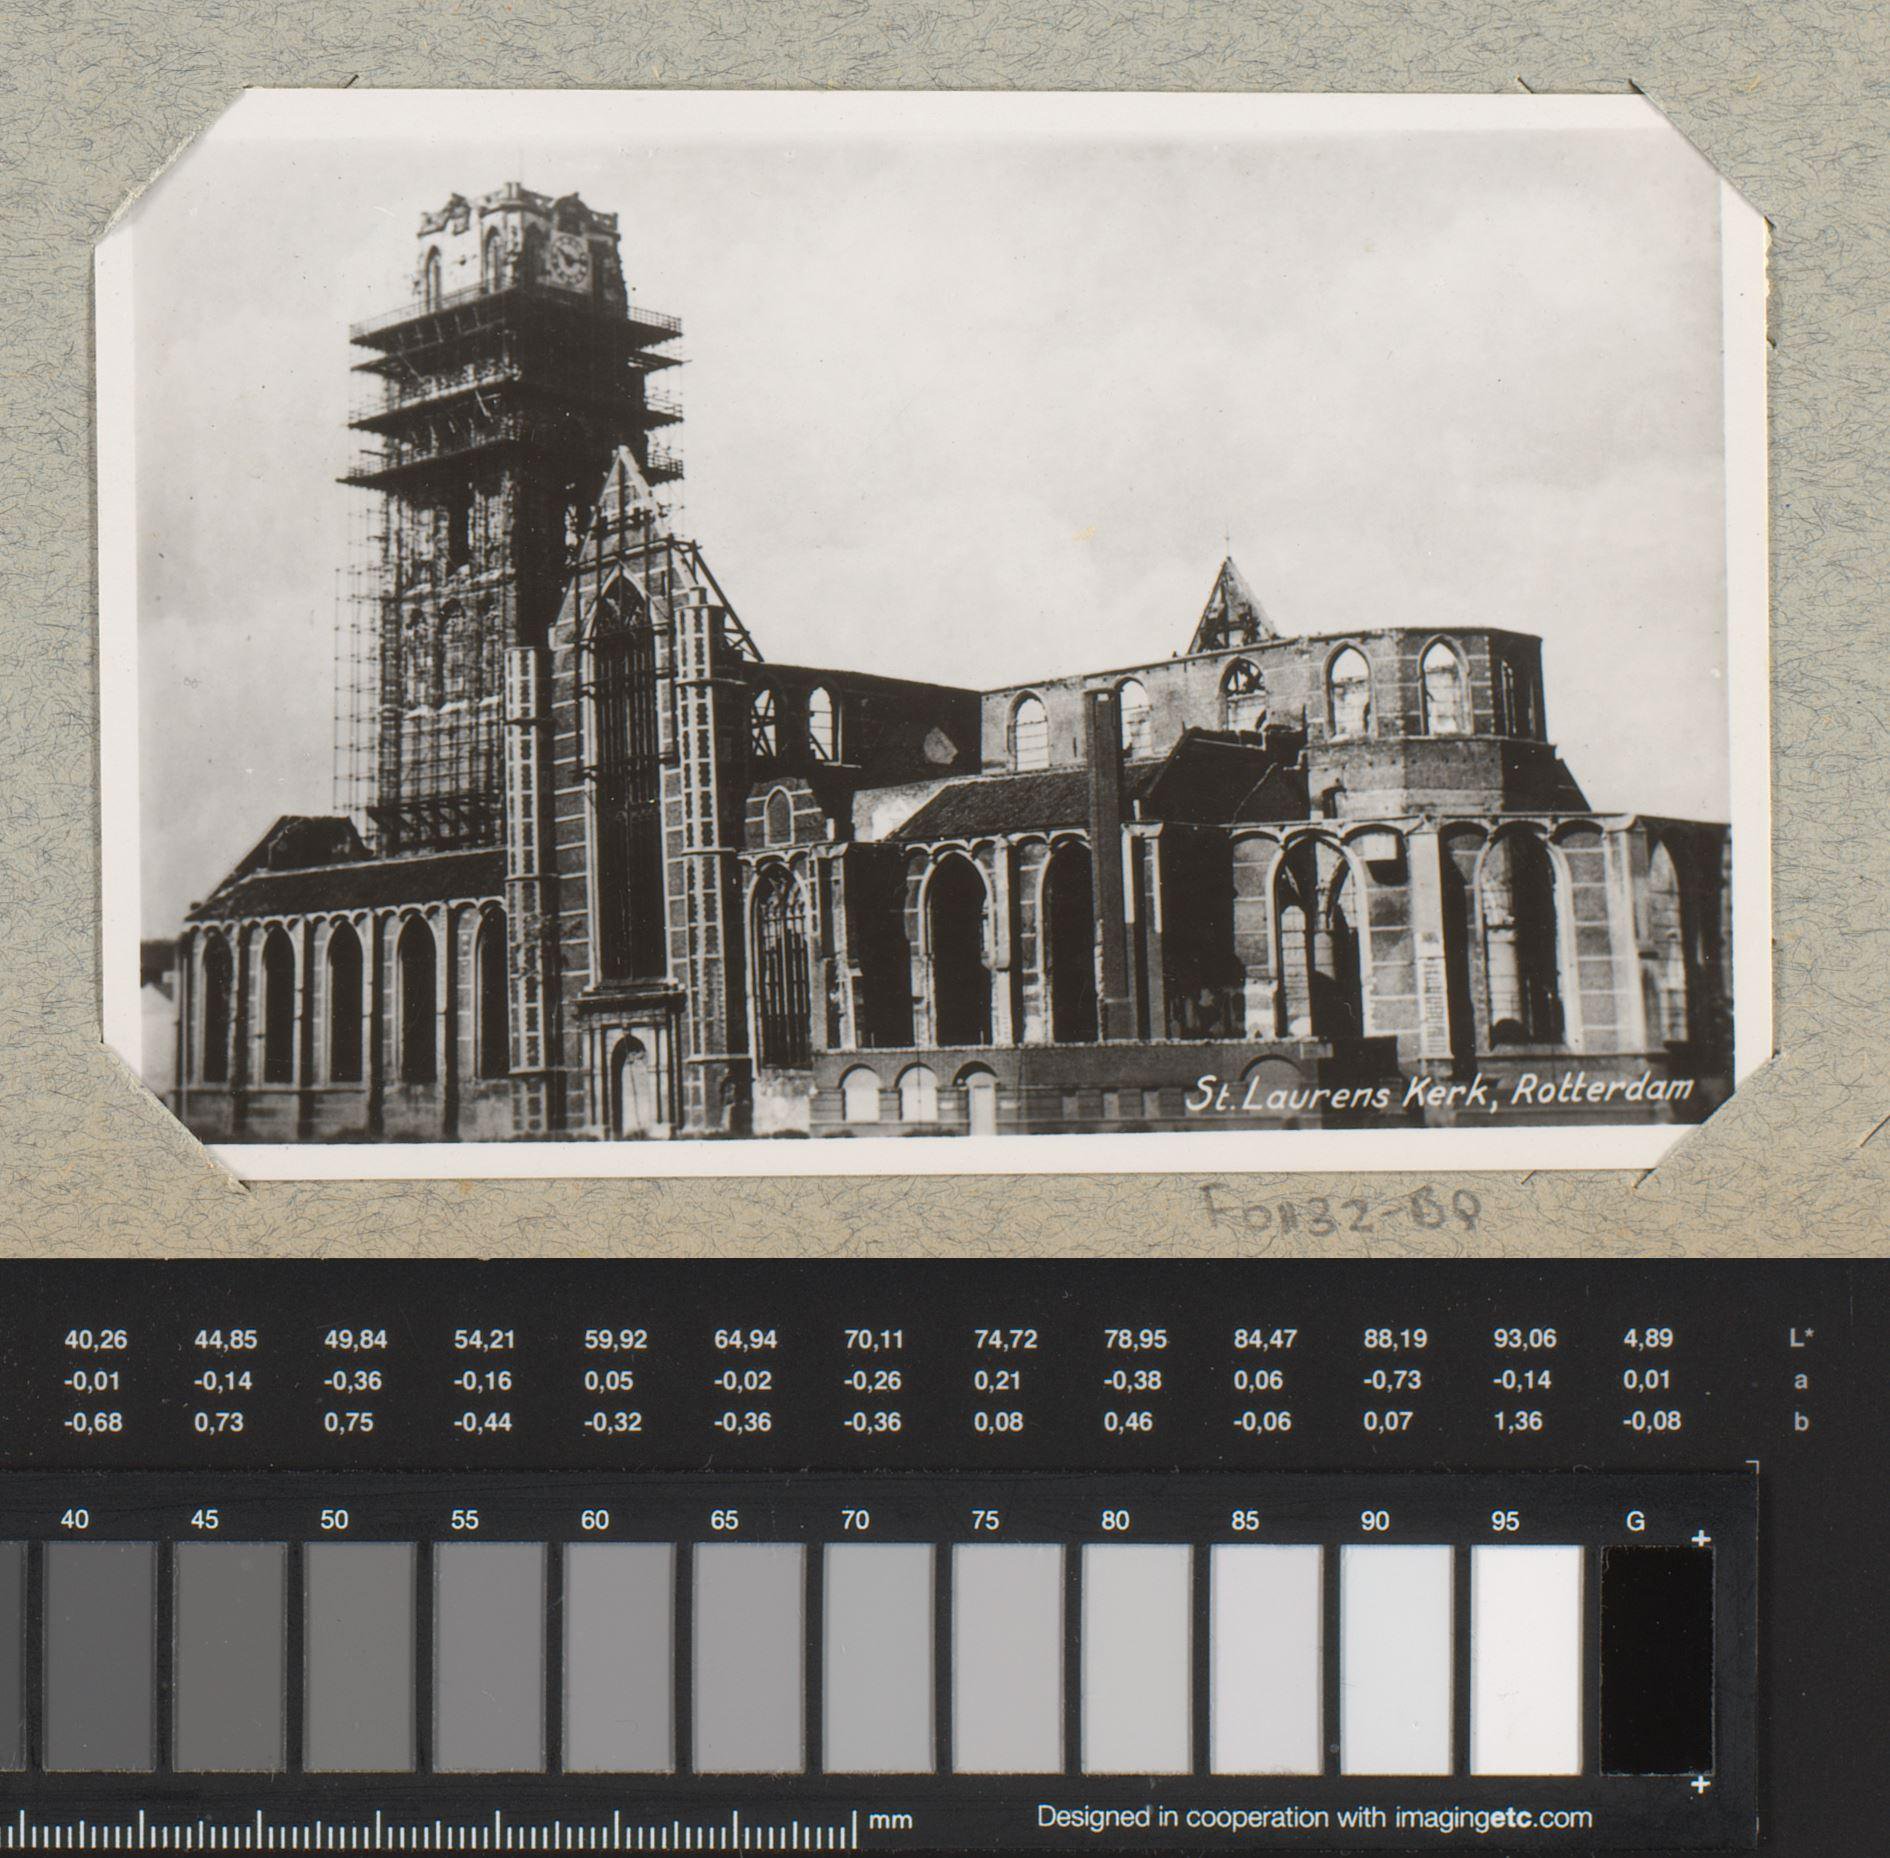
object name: ansichtkaart, prentbriefkaart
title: Geraamte van de Sint Laurens Kerk te Rotterdam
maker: j. nolte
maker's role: fotograaf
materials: photographic support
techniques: gelatin silver print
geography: rotterdam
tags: ruin of church, monastery, etc. - qq - small church, chapel, devastated, ruined place or city (~ warfare), rotterdam, rotterdam blitz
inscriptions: inscription: ‘St. Laurens Kerk, Rotterdam’